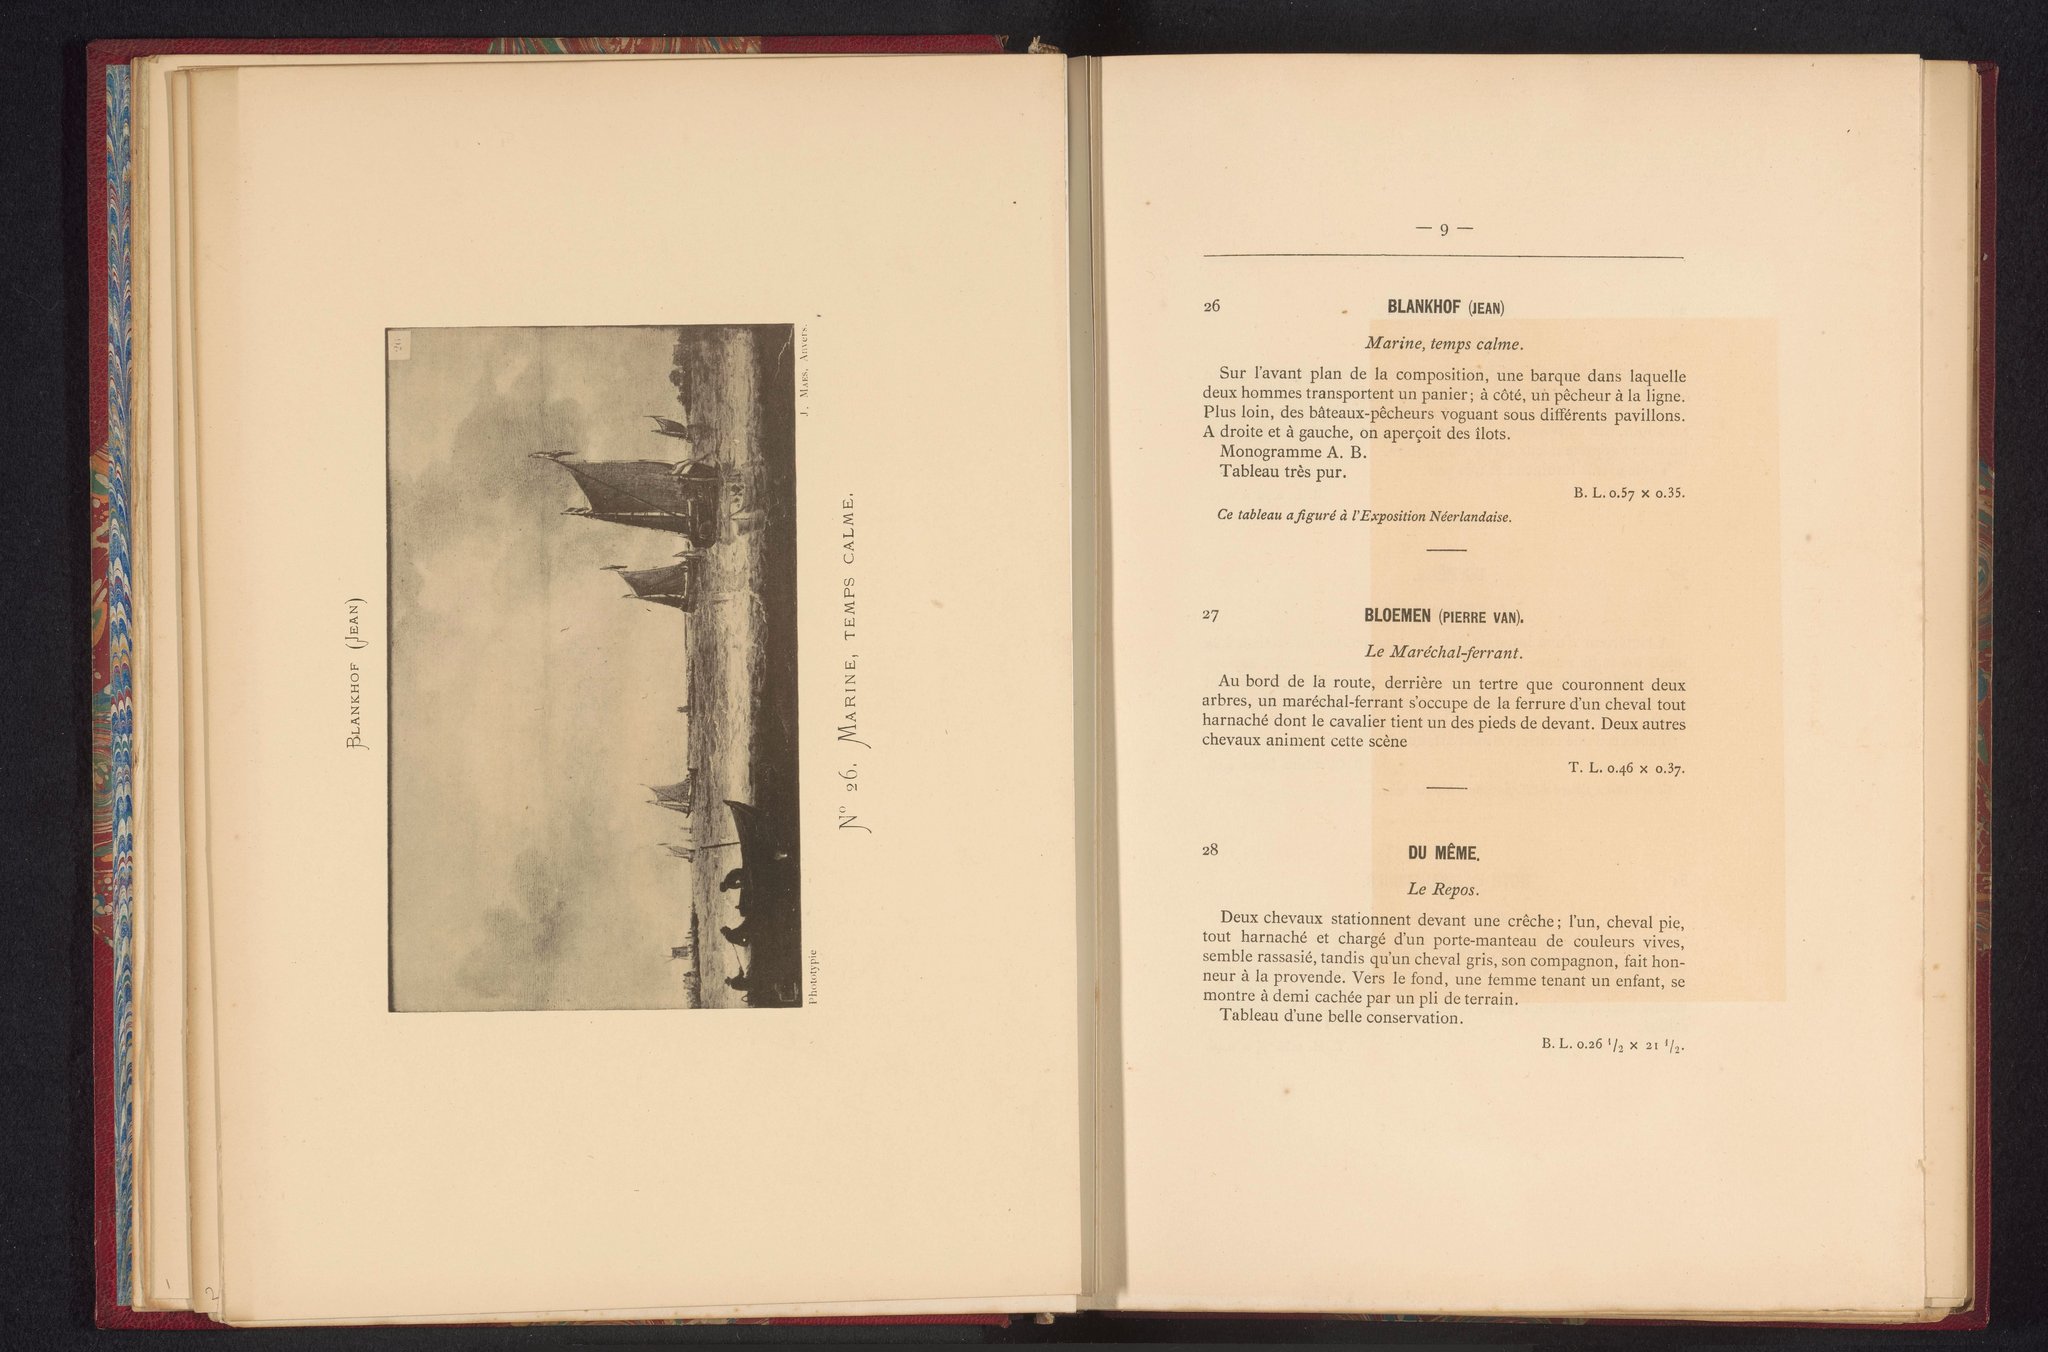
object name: photomechanical print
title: Reproductie van een geschilderd zeegezicht van Jan Theunisz. Blanckerhoff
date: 1878-1883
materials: paper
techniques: photograph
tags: sailing-ship, sailing-boat, landscapes with waters, waterscapes, seascapes (in the temperate zone), painting, drawing and the graphic arts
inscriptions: number: ‘No. 26’